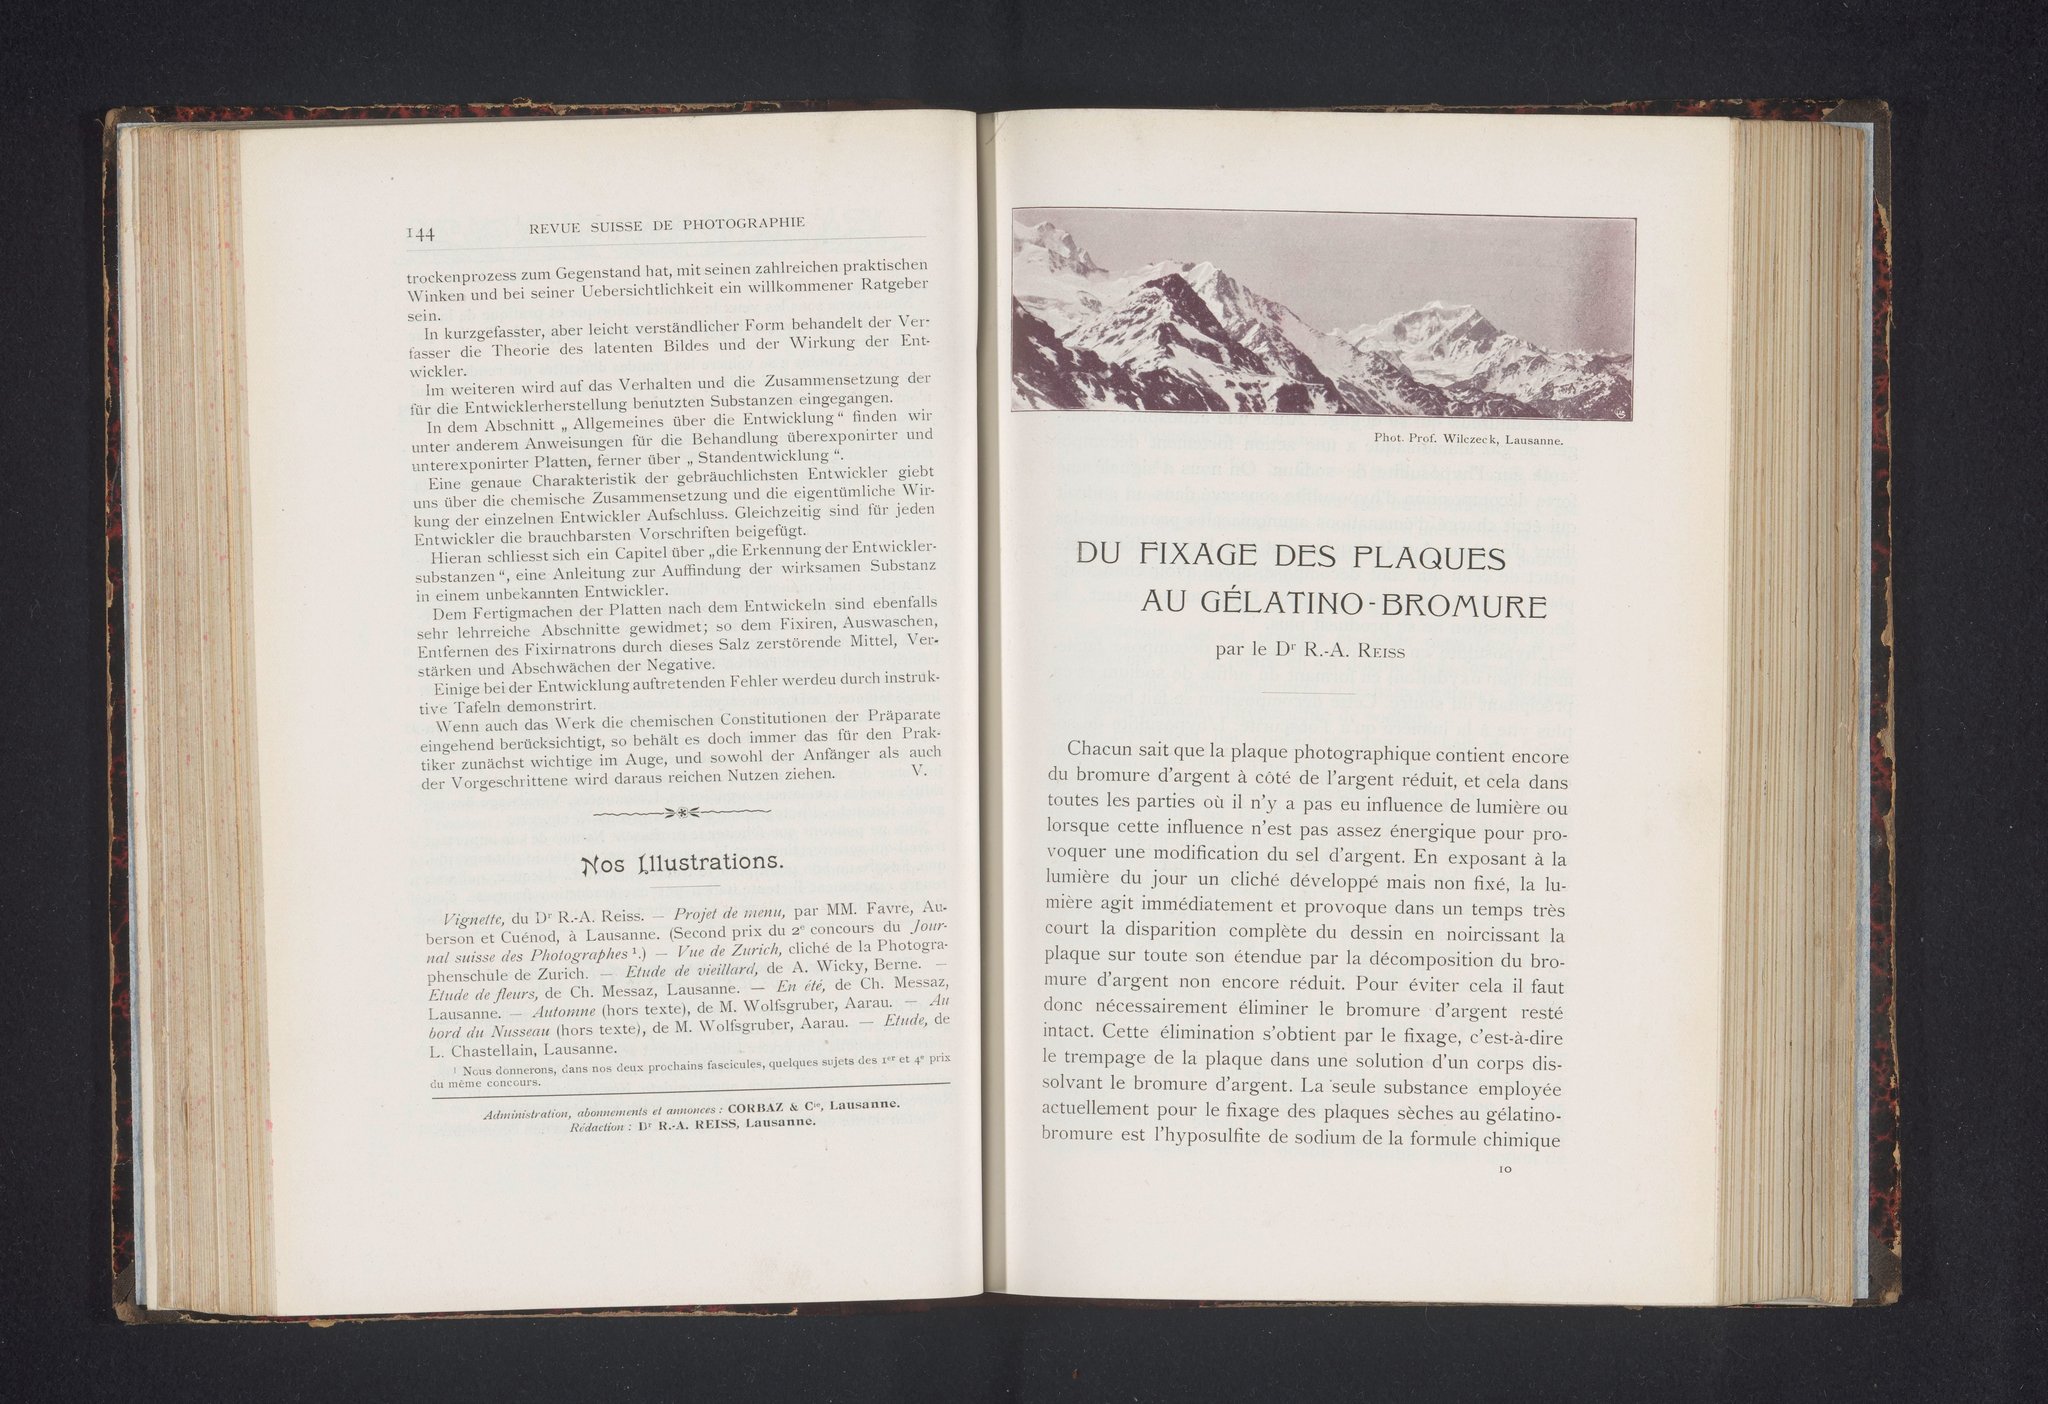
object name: photomechanical print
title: Bergketen in de sneeuw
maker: Anonymous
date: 1897-1902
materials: paper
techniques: autotype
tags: mountain-range, snow peaks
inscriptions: name: ‘Prof. Wilczeck’, monogram: ‘C. Cie’